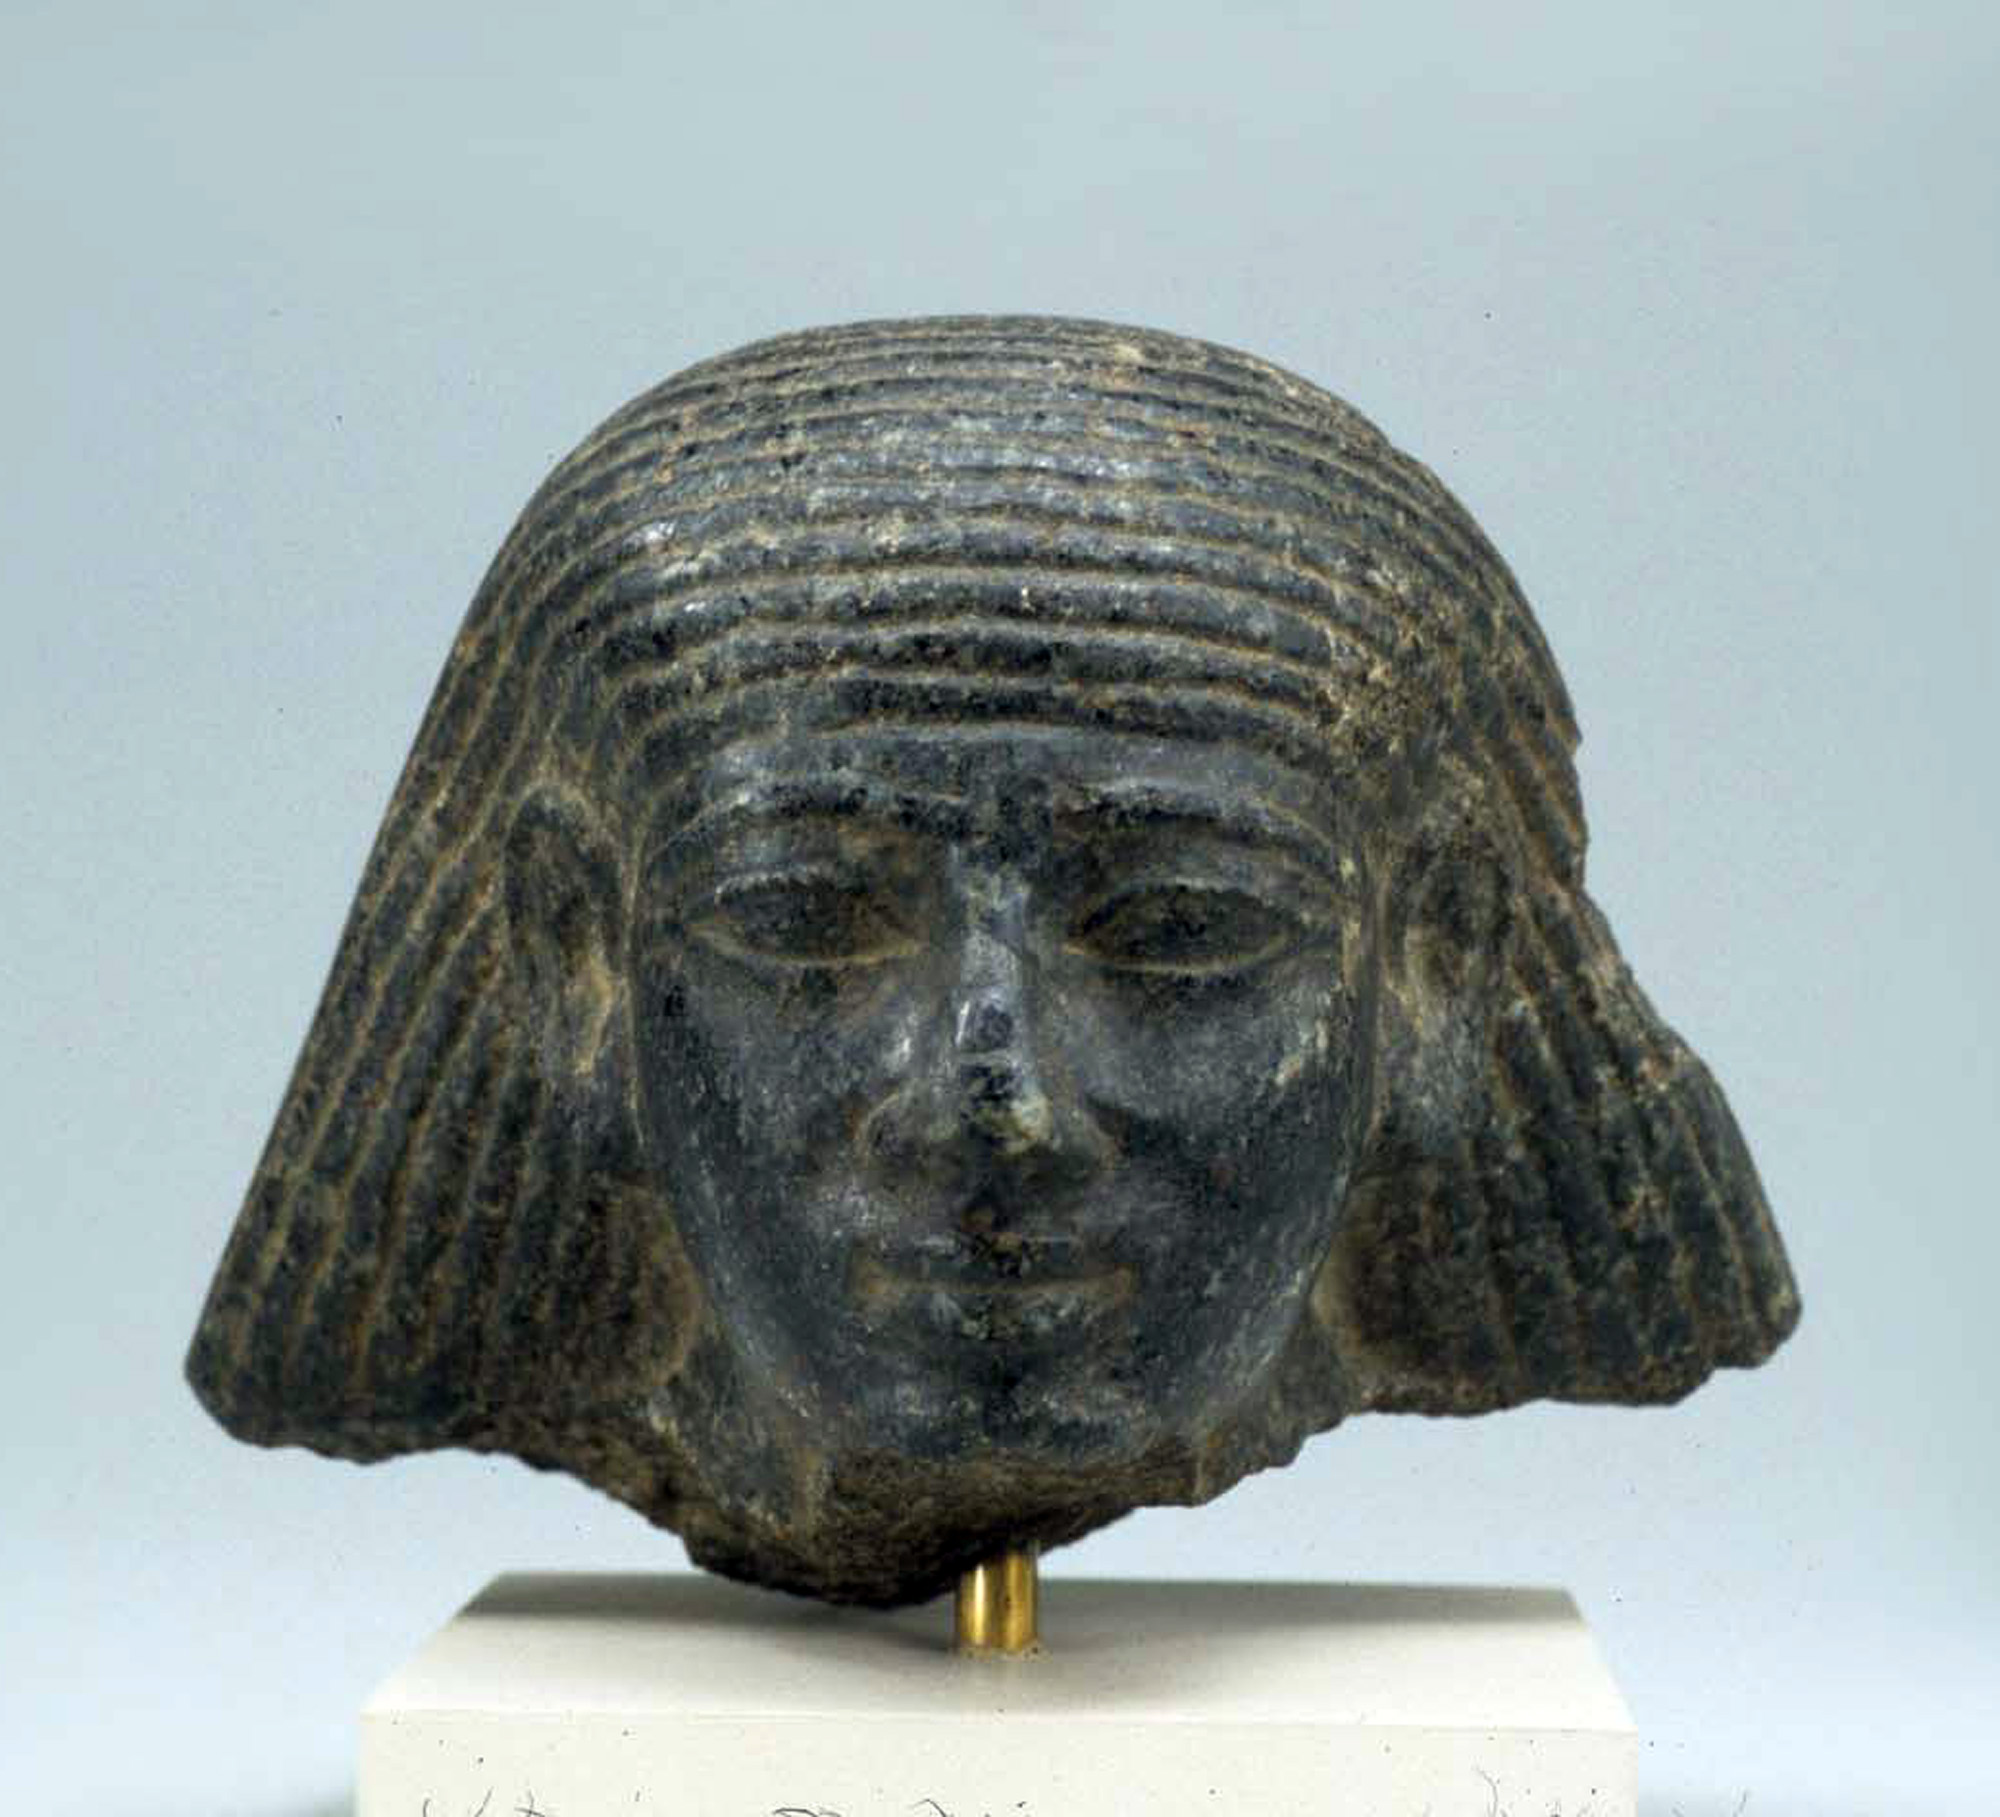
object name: head, man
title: Head of a Man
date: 1450-1350 BCE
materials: stone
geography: egypt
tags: heads,men